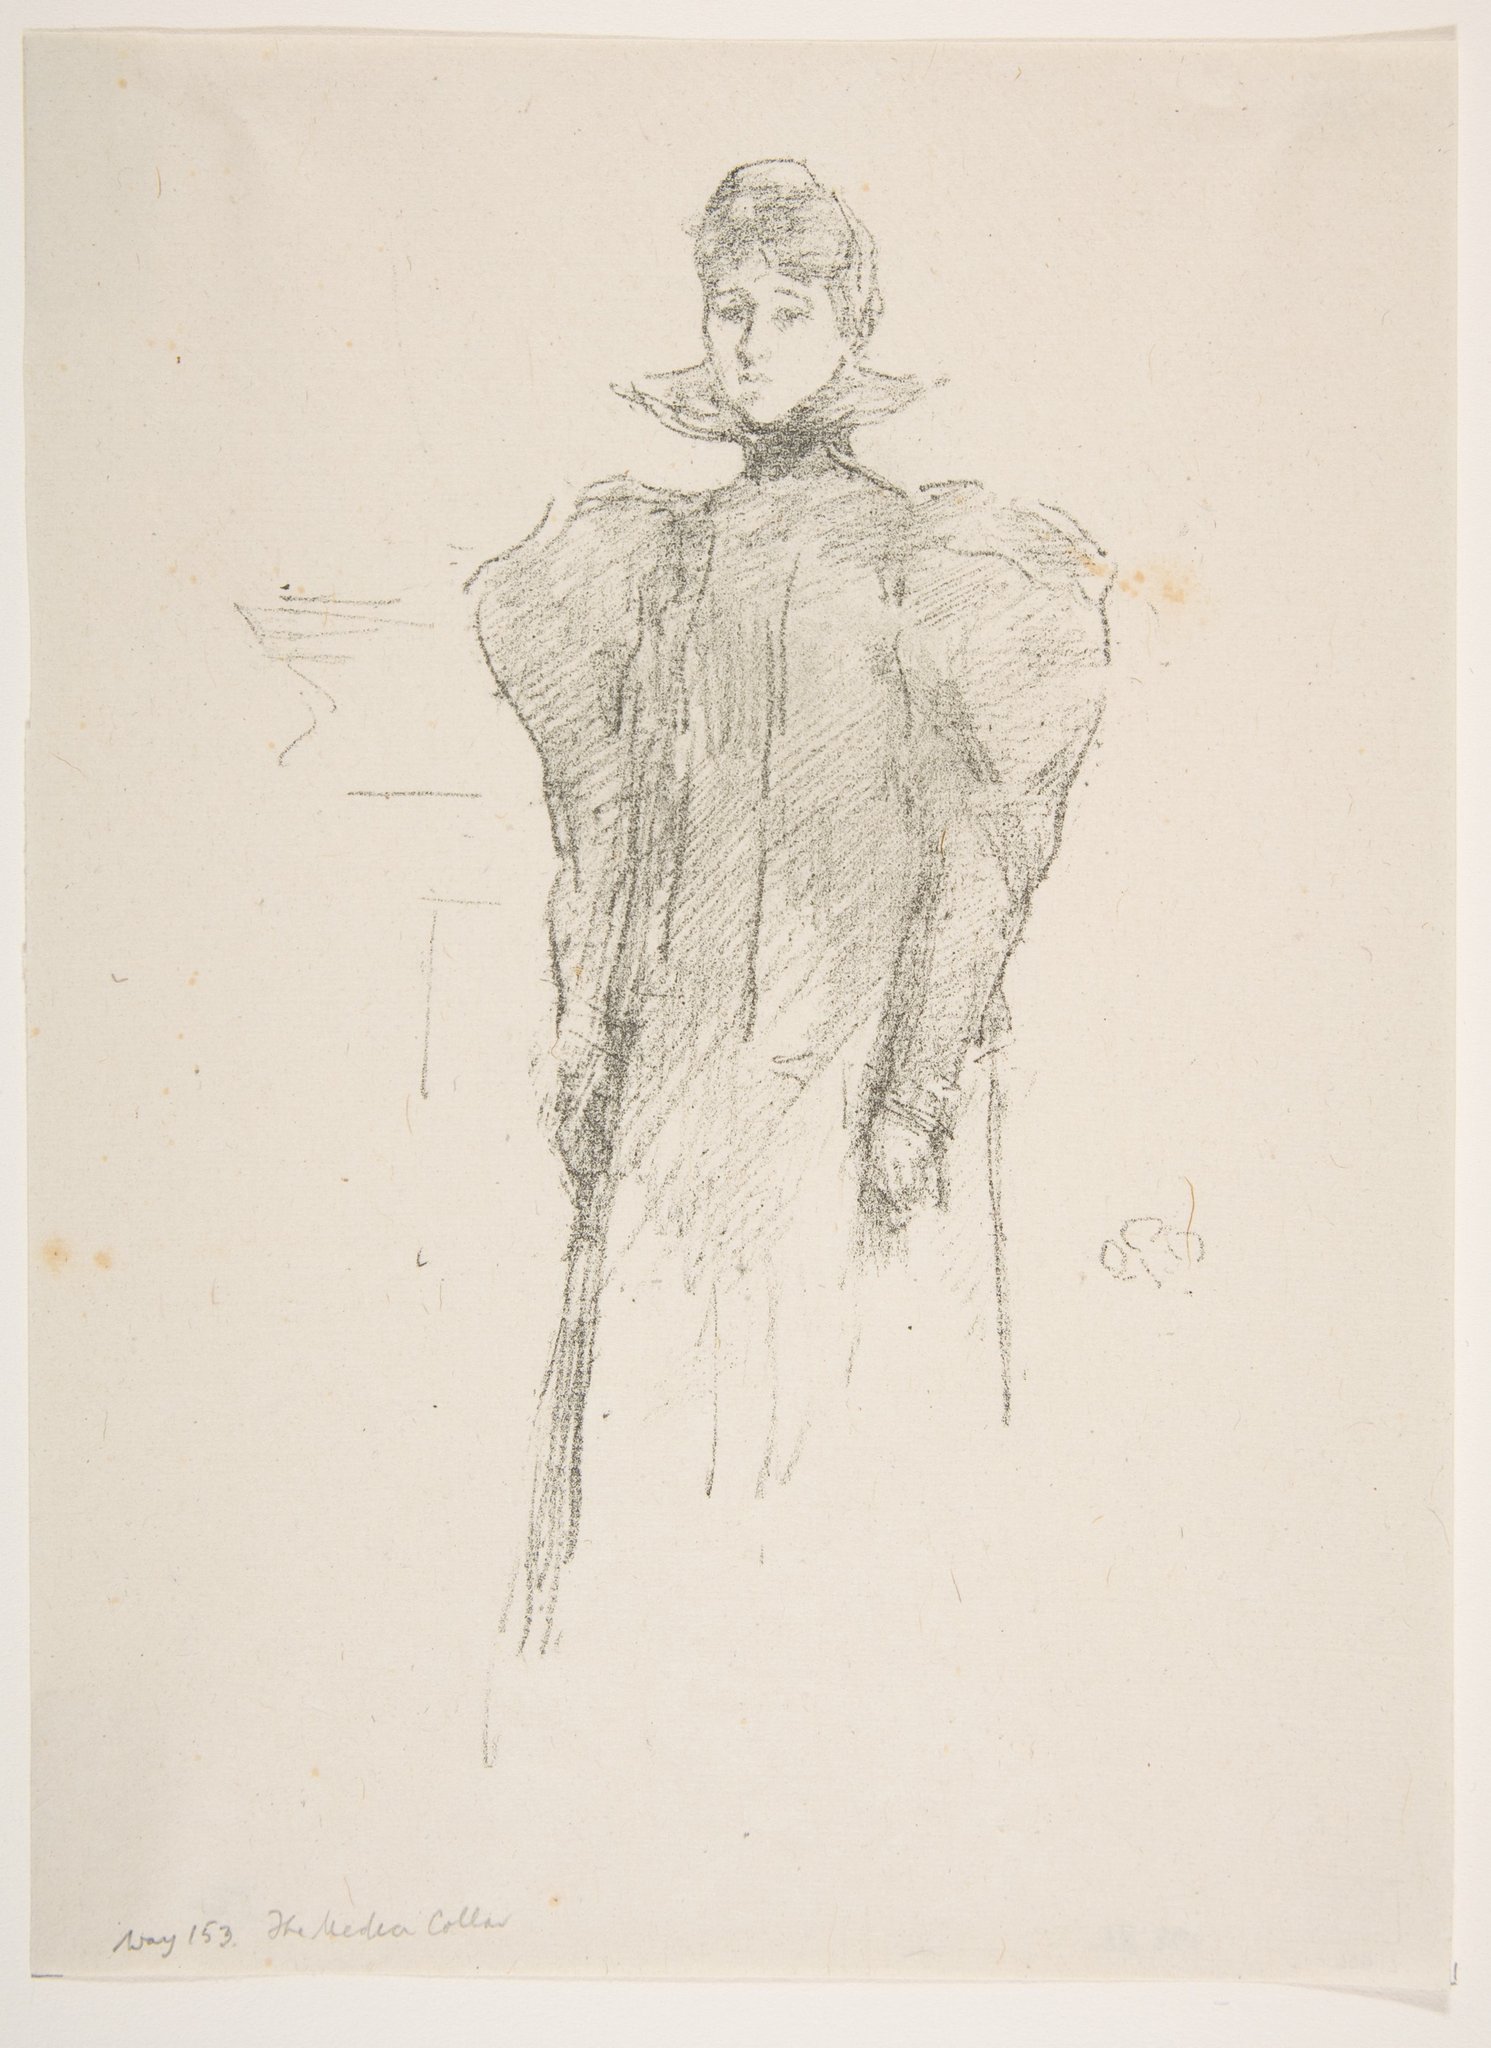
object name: print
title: The Medici Collar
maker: james mcneill whistler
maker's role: artist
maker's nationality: american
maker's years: 1834-1903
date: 1897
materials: paper, ink, ivory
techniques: printing, lithography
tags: women